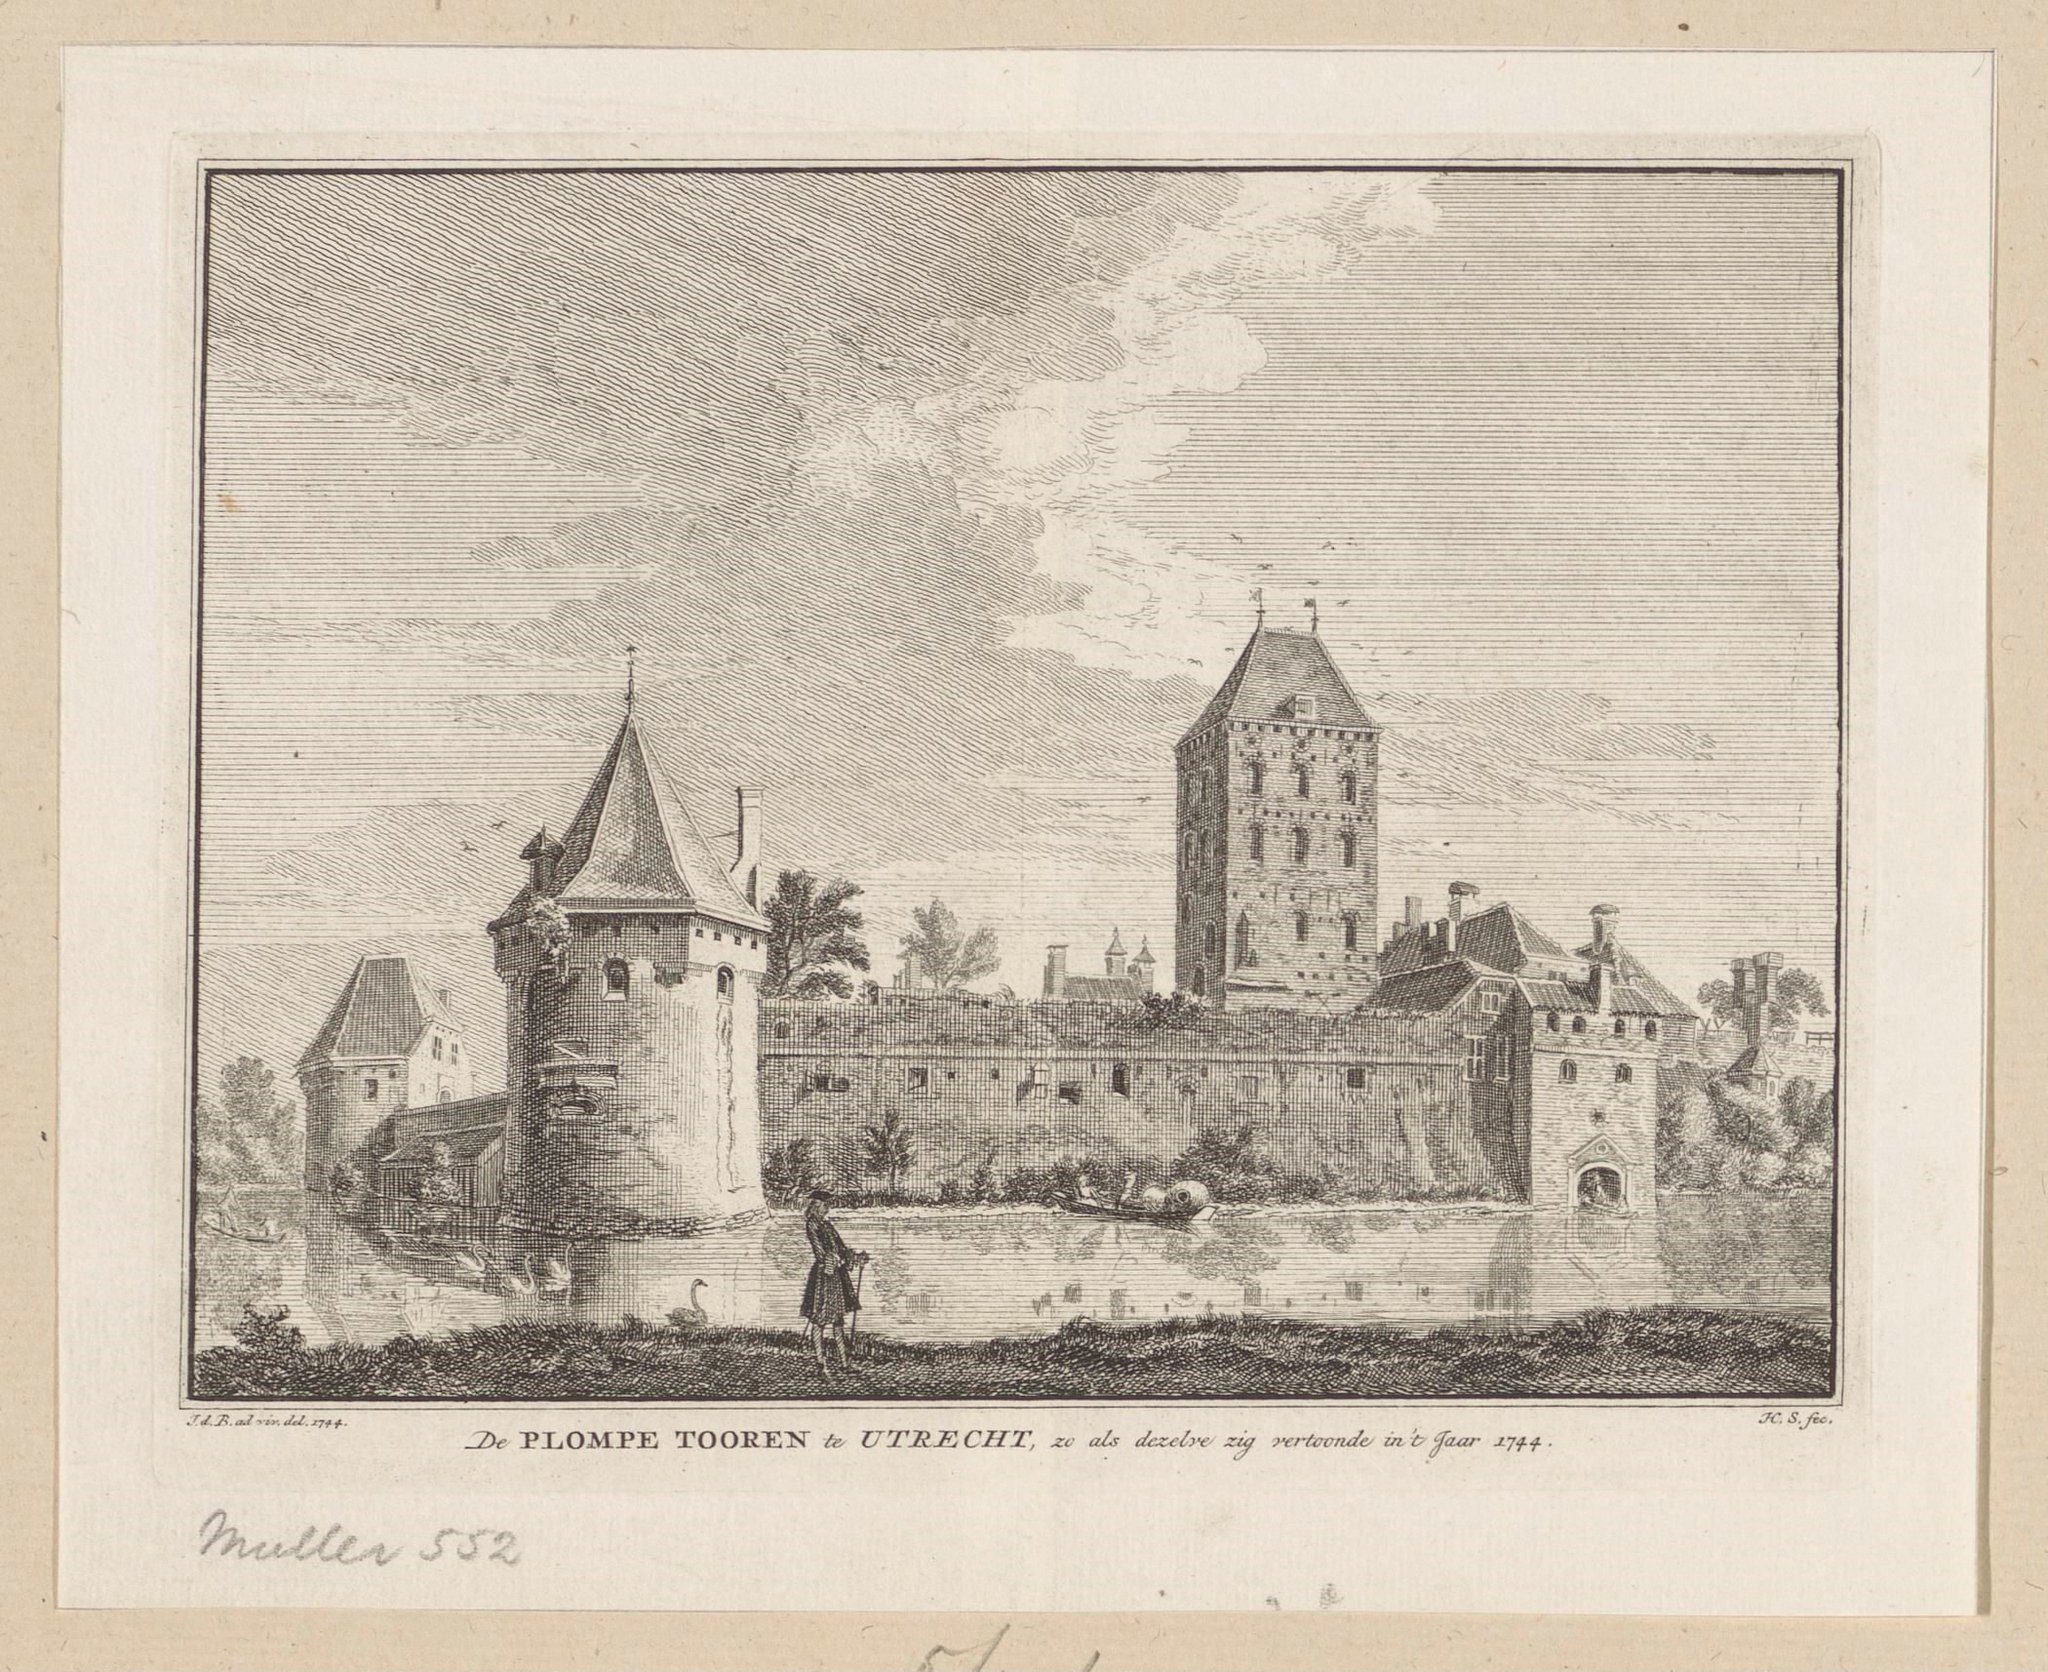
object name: print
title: Gezicht op de Plompetoren te Utrecht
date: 1773-1792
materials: paper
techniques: engraving, etching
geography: haarlem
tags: towers ~ fortified city, city-walls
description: Prent ook gebruikt in: Het verheerlykt Nederland of kabinet van hedendaagsche gezigten van steden, dorpen (…) Behelzende honderd gezigten van der Provincie van Utrecht. Amsterdam: weduwe Isaak Tirion, 1773-1774, dl. 7, 8 of 9, niet genummerd, te vinden na ill. 144 en voor ill. 201. Of in: Nederlandsche tafereelen; of eene keurige verzameling van negen honderd fraaije gezigten van steden, dorpen, sloten, oudheden (….). 9 delen. Amsterdam: Jan de Groot, 1792, dl. 7, 8 of 9, niet genummerd, te vinden na ill. 144 en voor ill. 201. Uit welke druk het huidige exemplaar precies komt is niet na te gaan.